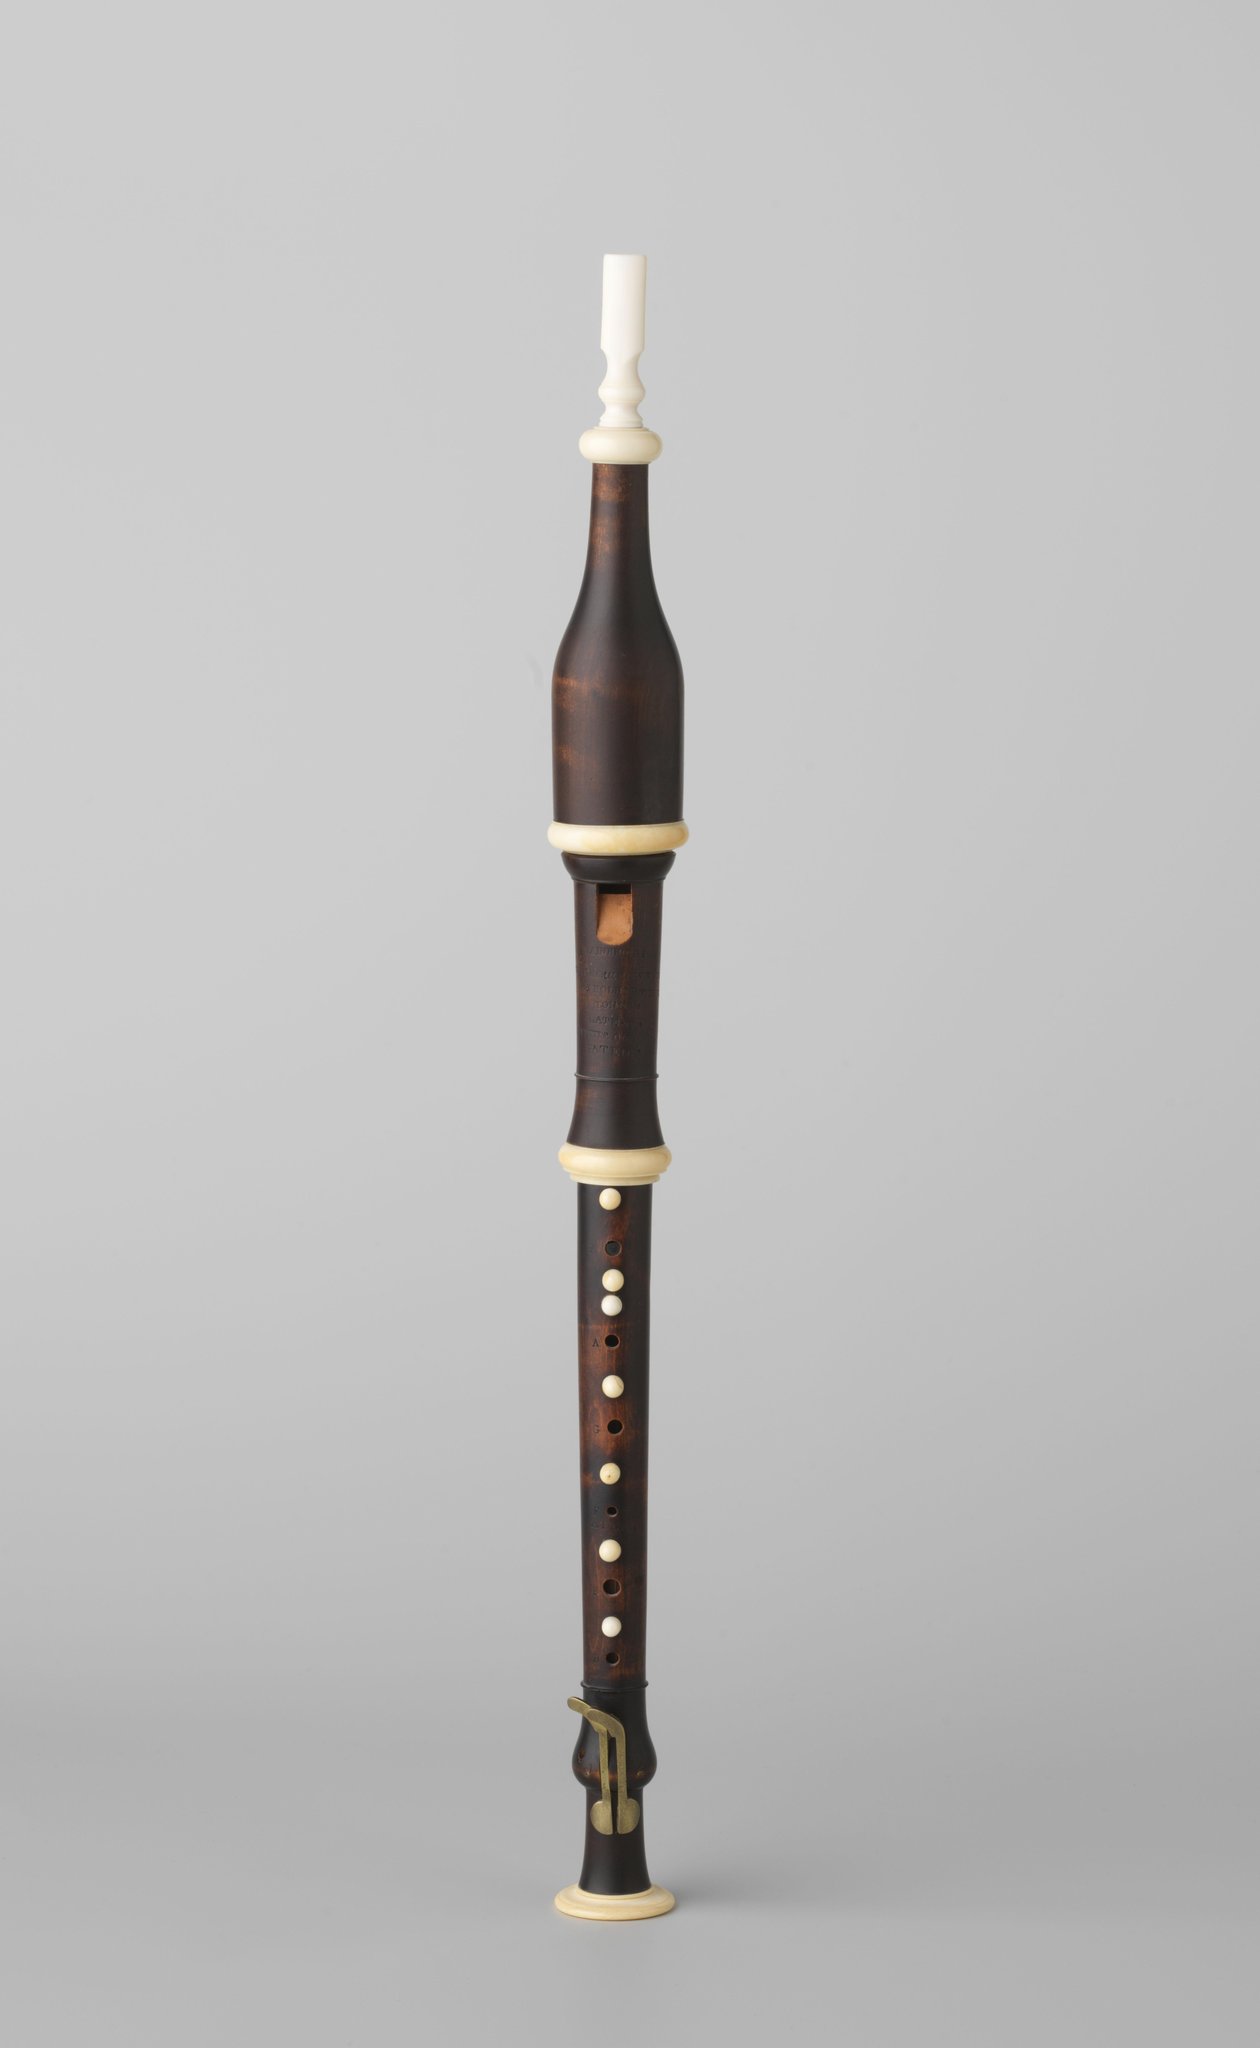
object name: musical instrument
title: Flageolet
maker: william bainbridge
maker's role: musical instrument maker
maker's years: 1768-1831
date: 1808-1820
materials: wood, brass, ivory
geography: london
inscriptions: stamp: ‘BAINBRIDGE / TEACHER & INVENTOR / 35 HOLBORN HILL /LONDON / LATE OF / 2 LITTLE QUEENS / PATENT’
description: Enkele engelse flageolet in gebeitst buxus met twee messing kleppen en ivoren ringen en mondstuk. Het instrument is gaaf bewaard gebleven en is nog goed speelbaar. Laagste toon is een d’‘, uitgaande van een stemming van a-415 Hz. Stempels en markeringen: middendeel: BAINBRIDGE / TEACHER & INVENTOR / 35 HOLBORN HILL /LONDON / LATE OF /2 LITTLE QUEENS / PATENT; onderstuk met vingergaten: nummers en notenaanduidingen voor elk gat en klep.